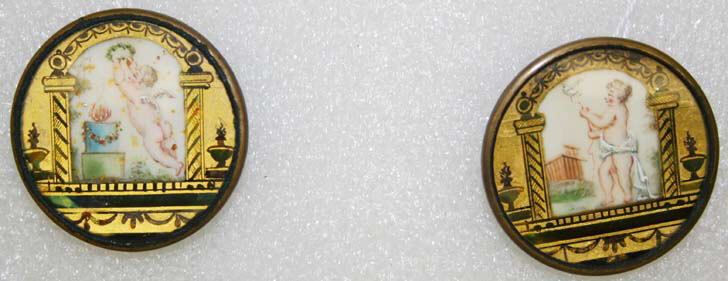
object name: button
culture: french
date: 1775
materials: glass, ivory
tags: putti